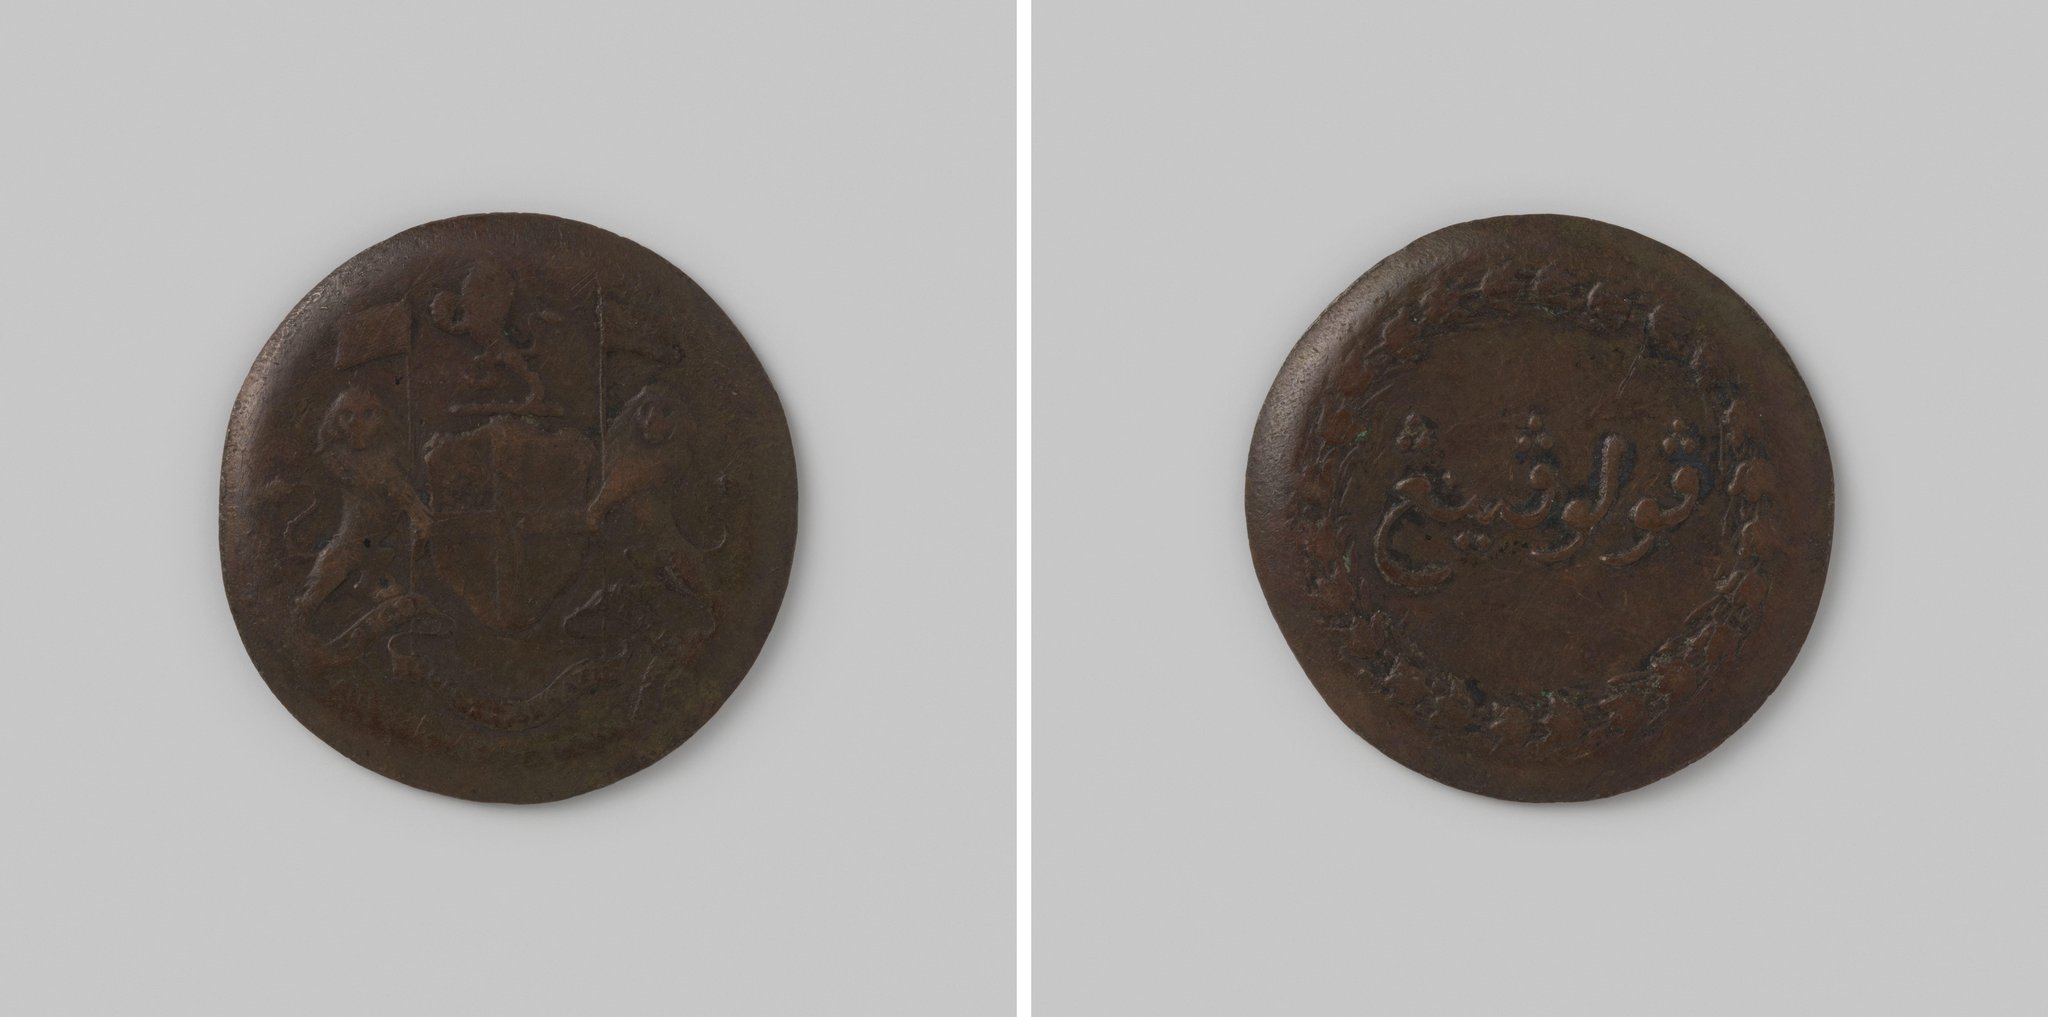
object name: coin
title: Malakka, Pulu Penang, cent, (1810-1828)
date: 1810-1828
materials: copper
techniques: striking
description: Koperen munt. Voorzijde: door twee op banderol, waarin opschrift, staande leeuwen met pijl, waaraan vlag, in de klauw, gehouden wapenschild van de EIC, waarboven helmteken. Niet-leesbaar jaartal onderaan. Keerzijde: binnen krans van bladeren eenregelig opschrift in het Maleis in Arabische lettertekens: pulu penang. Munt is gesnoeid.